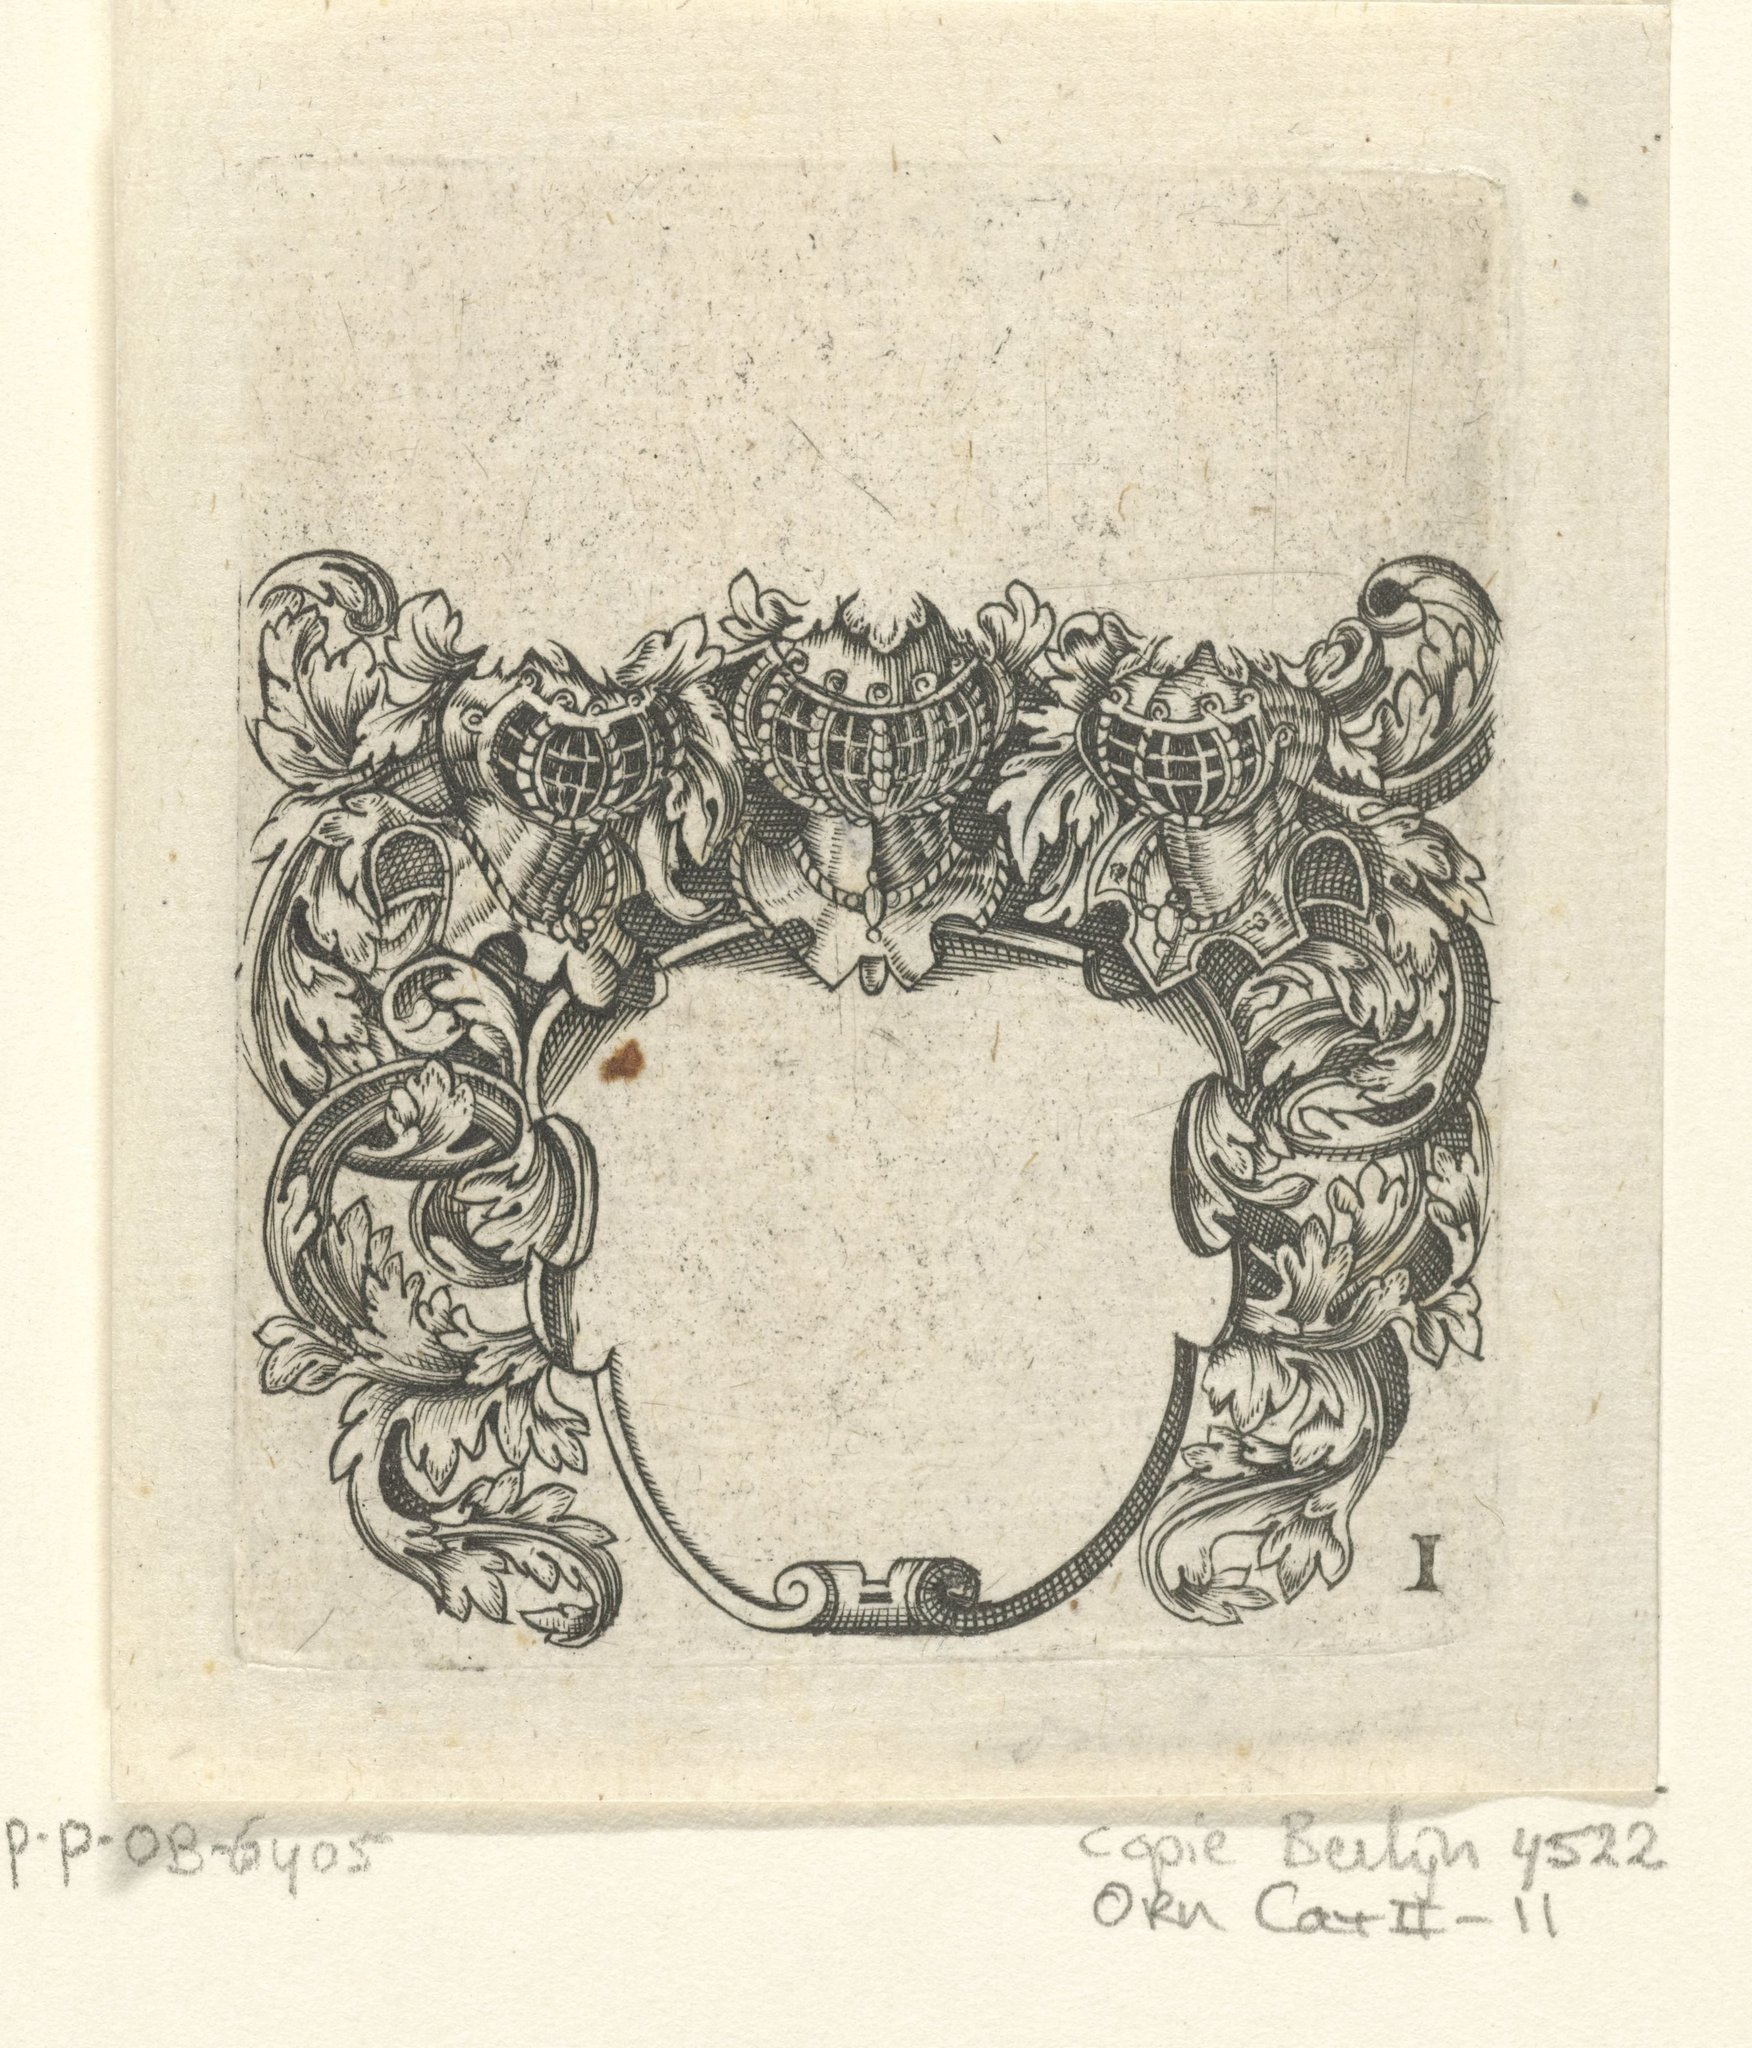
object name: ornament print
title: Wapenschild met drie helmen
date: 1625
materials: paper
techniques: engraving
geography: amsterdam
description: Tegenzijdige kopie naar wapenschild van Theodor de Bry in het boek Emblemata Nobilitati.... Blad uit serie wapenschilden met lege compartimenten.